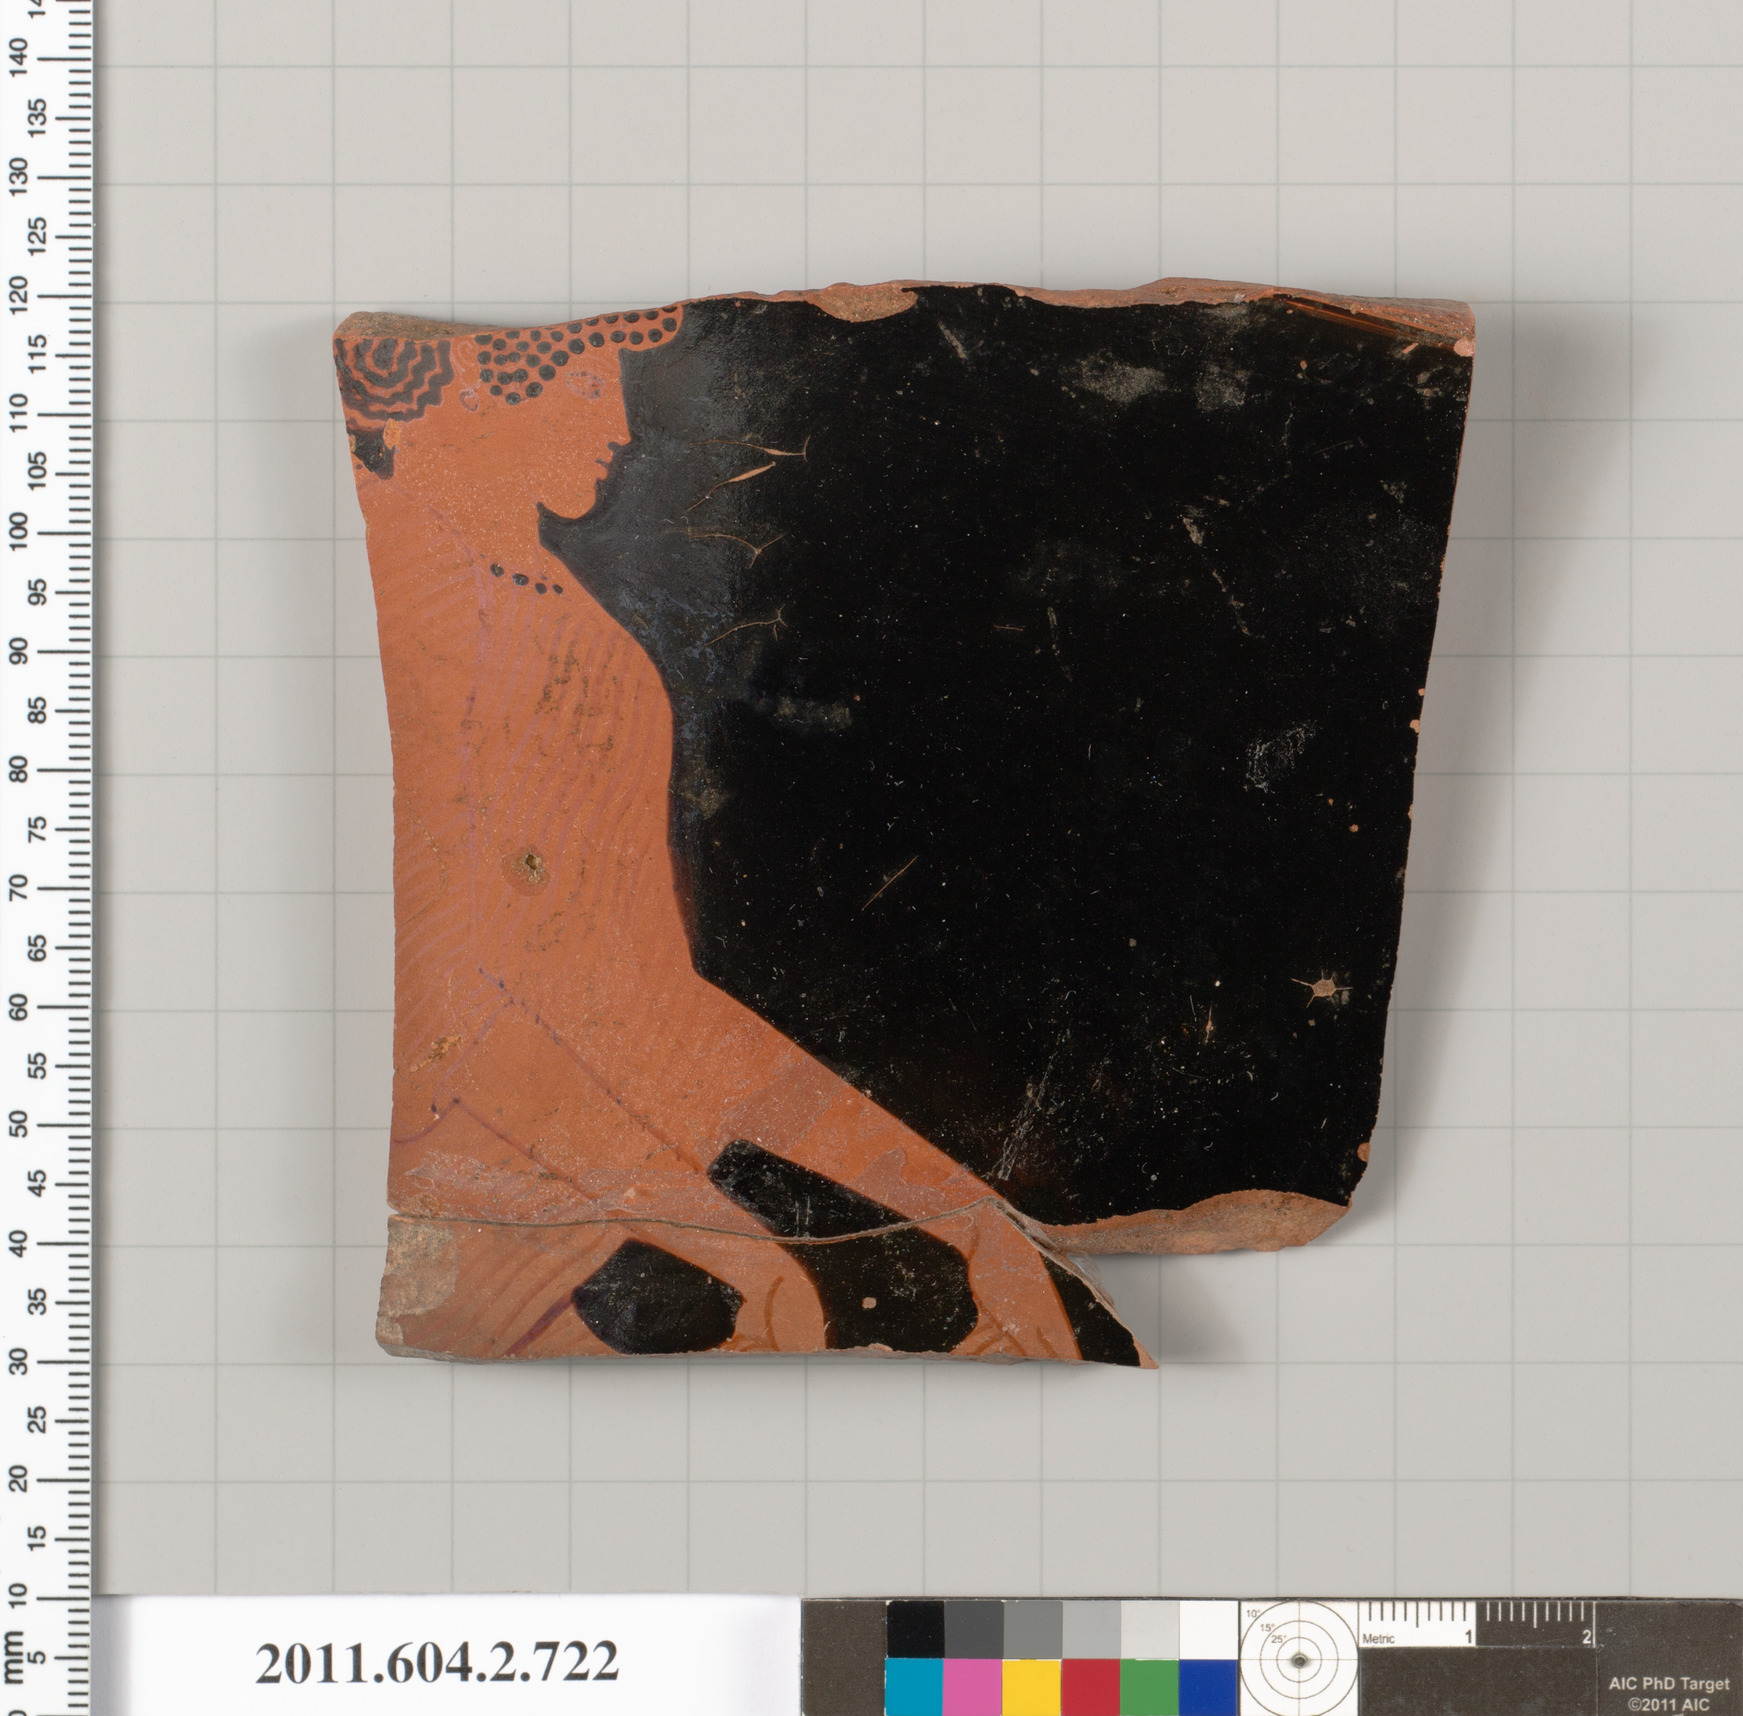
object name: calyx krater fragment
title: Terracotta fragment of a calyx-krater (bowl for mixing wine and water)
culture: greek, attic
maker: aegisthus painter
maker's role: artist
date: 460-450 BCE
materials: terracotta